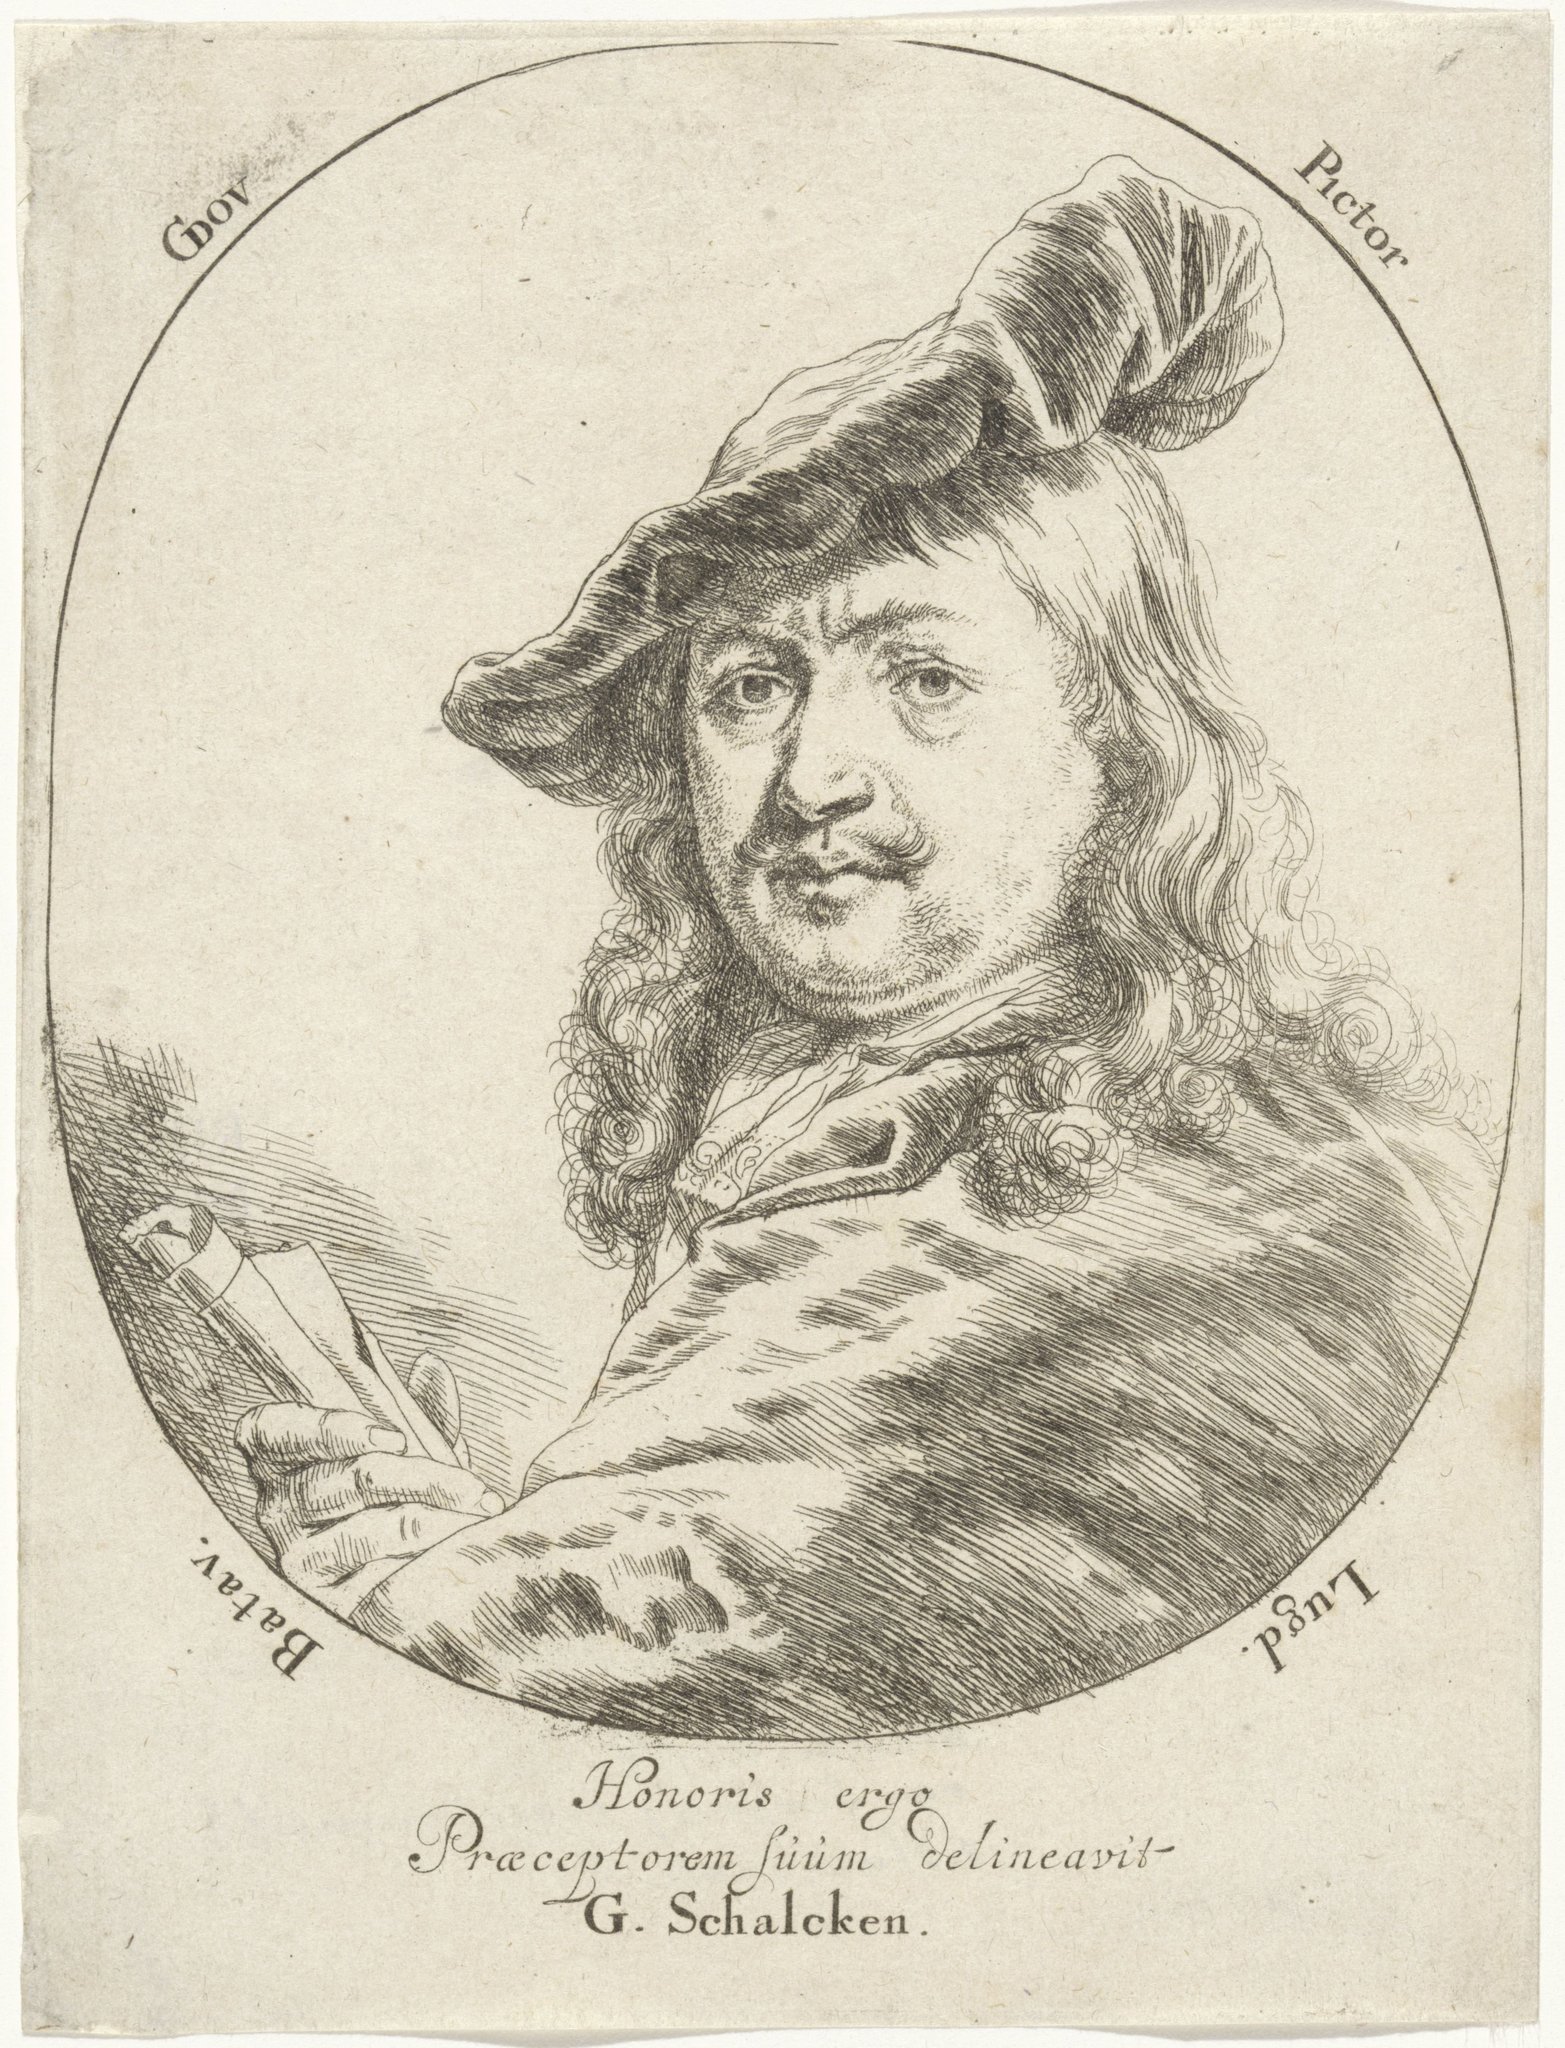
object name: print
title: Portret van Gerard Dou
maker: godfried schalcken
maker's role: draughtsman, painter, print maker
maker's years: 1643-1706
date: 1660-1680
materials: paper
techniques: etching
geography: leiden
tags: leiden, painter, draughtsman, gerard dou, portrait, self-portrait of painter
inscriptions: collector's mark: Lugt 2760, collector's mark: Lugt 2166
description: Buste van de kunstenaar Gerard Dou in een ovale omlijsting. Dou draagt een baret en houdt een opgerold stuk papier vast. Rondom de lijst de Latijnse vertaling van: G. Dou, schilder, Leiden. Onder het portret de Latijnse vertaling van: Ter ere van zijn leraar heeft G. Schalcken getekend.